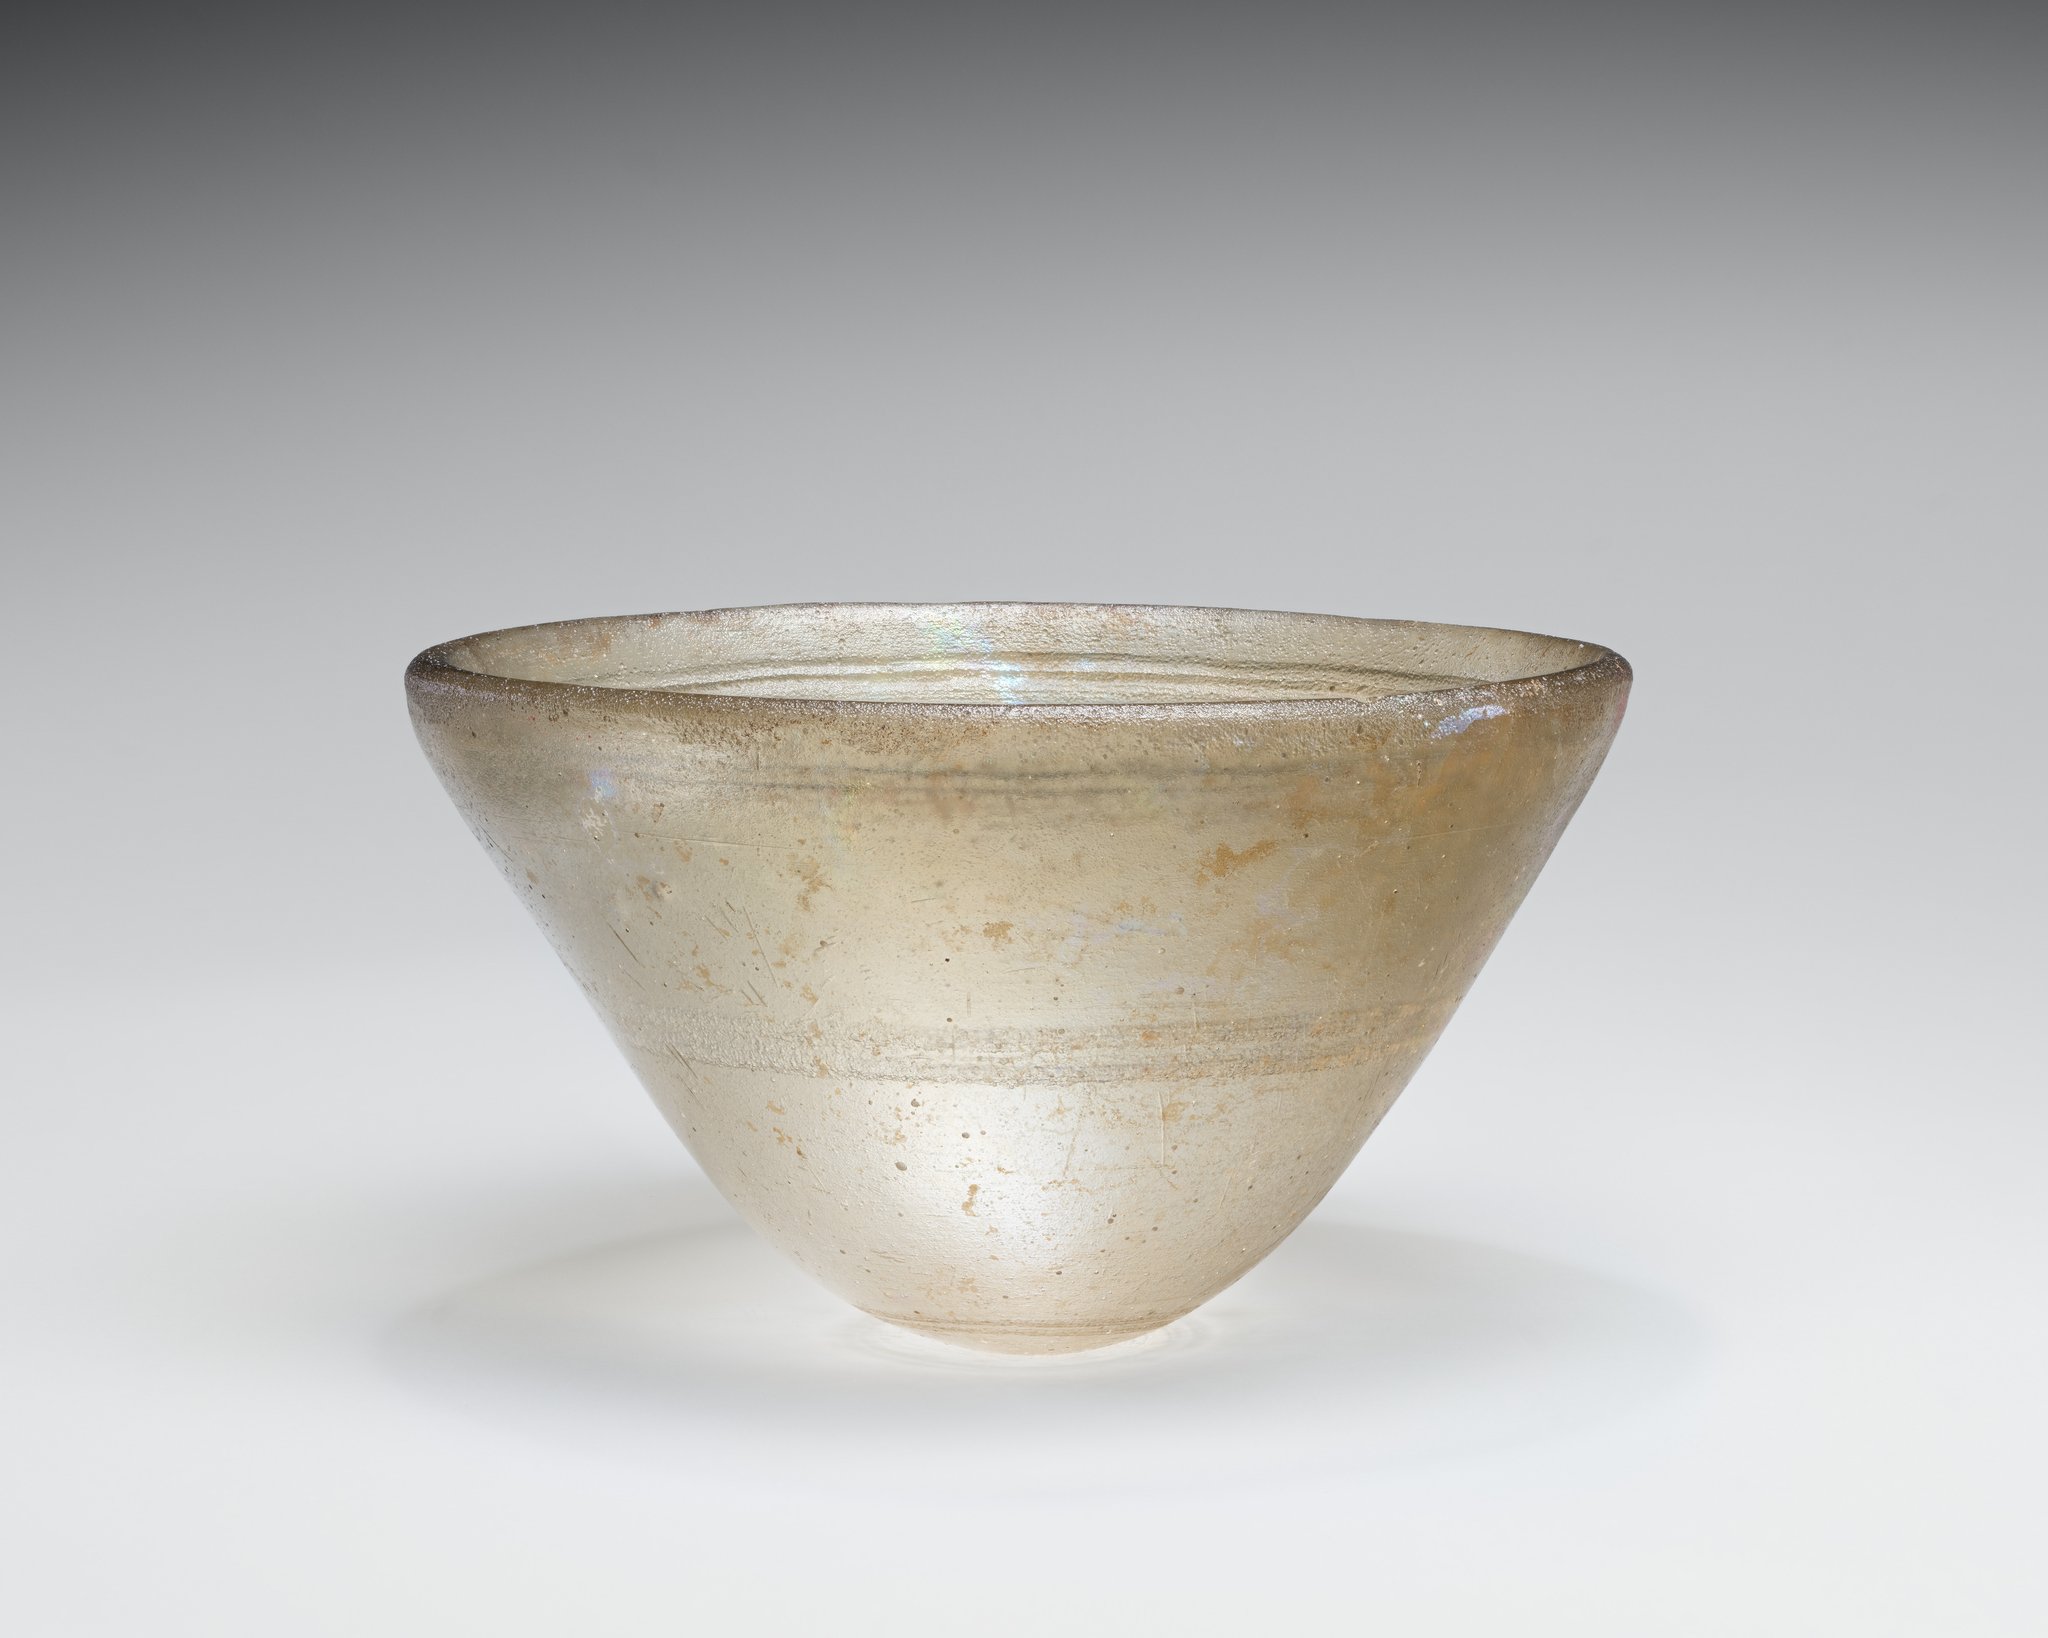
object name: bowl, mastos shaped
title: Glass conical bowl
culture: greek, eastern mediterranean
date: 167-68 BCE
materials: glass